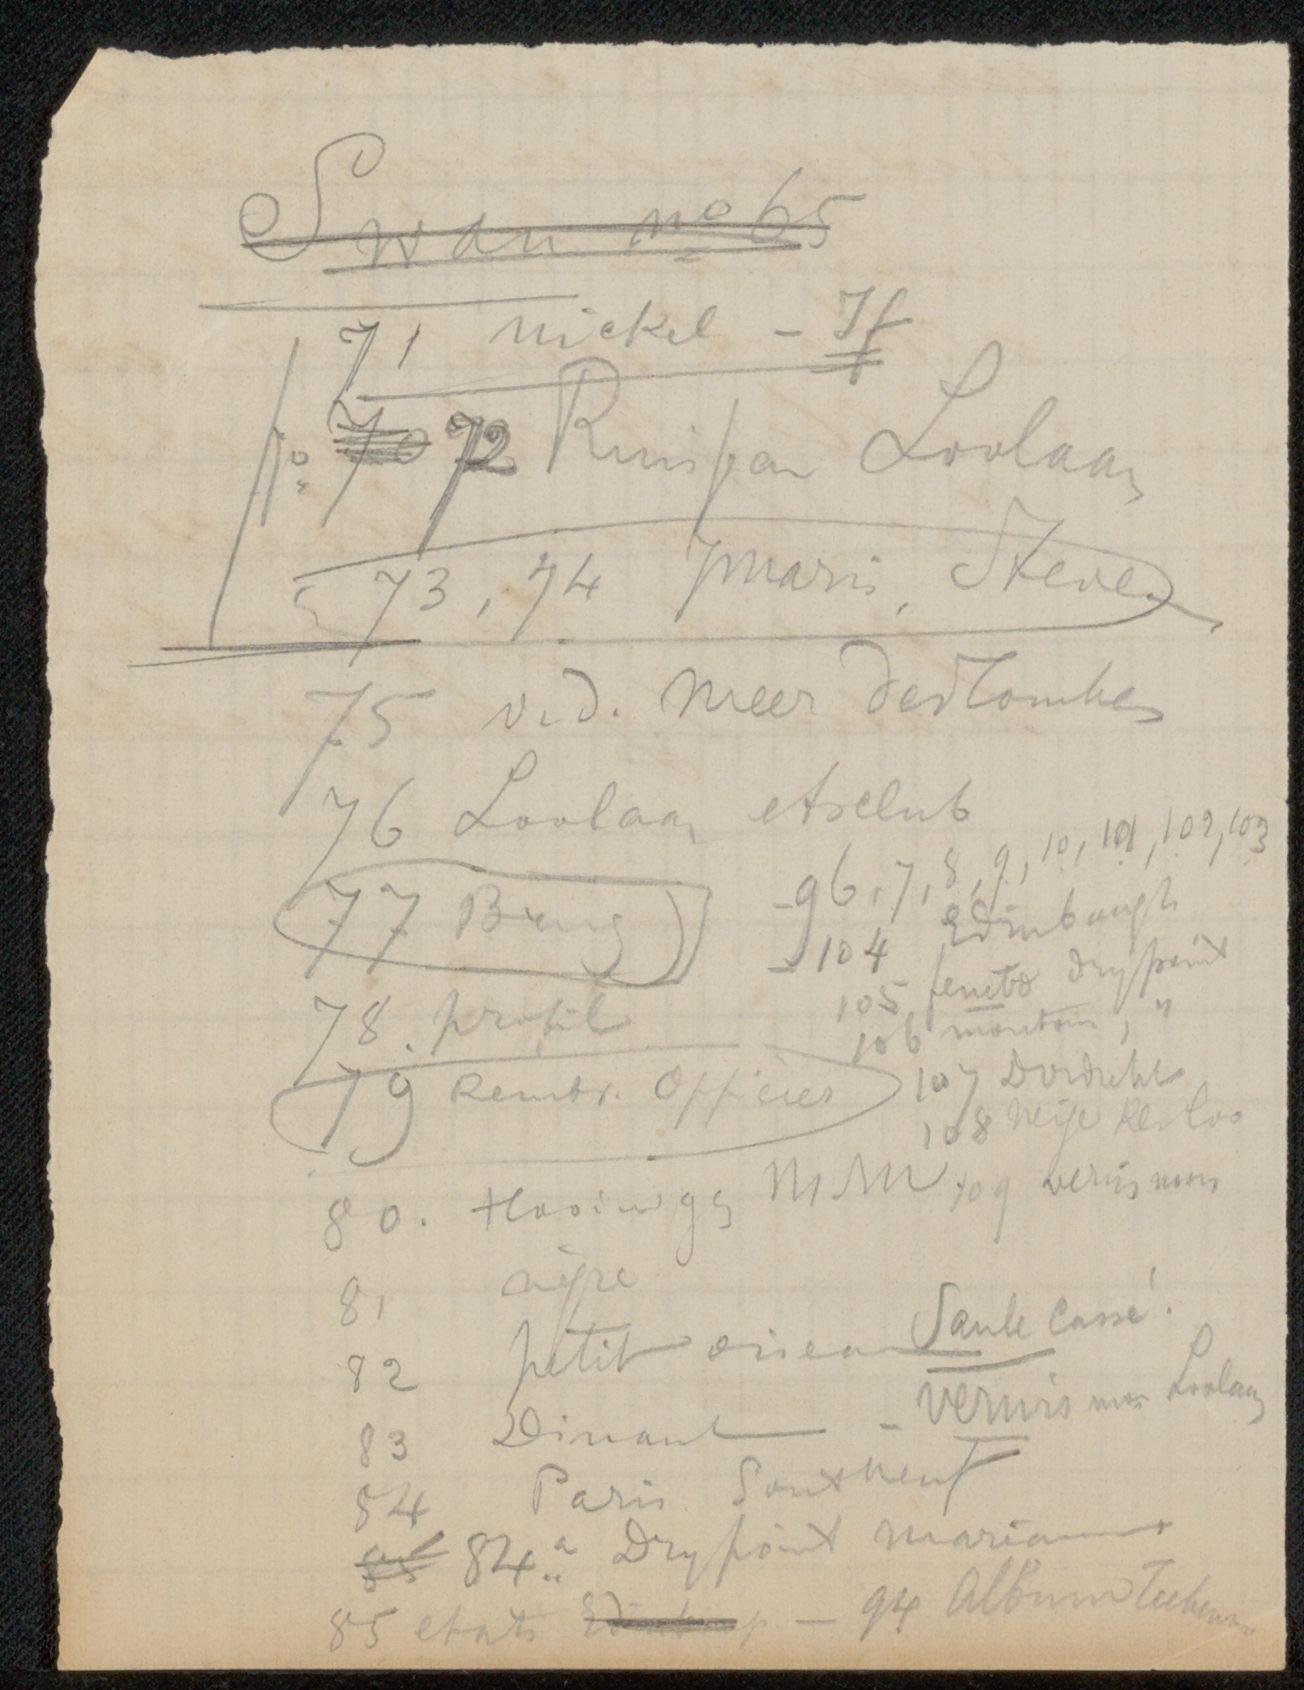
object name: aantekening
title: Aantekening uit archief Philip Zilcken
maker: philip zilcken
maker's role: draughtsman, painter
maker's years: 1857-1930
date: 1867-1930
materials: pencil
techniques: writing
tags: the hague, painter, draughtsman, jacob maris, the graphic arts